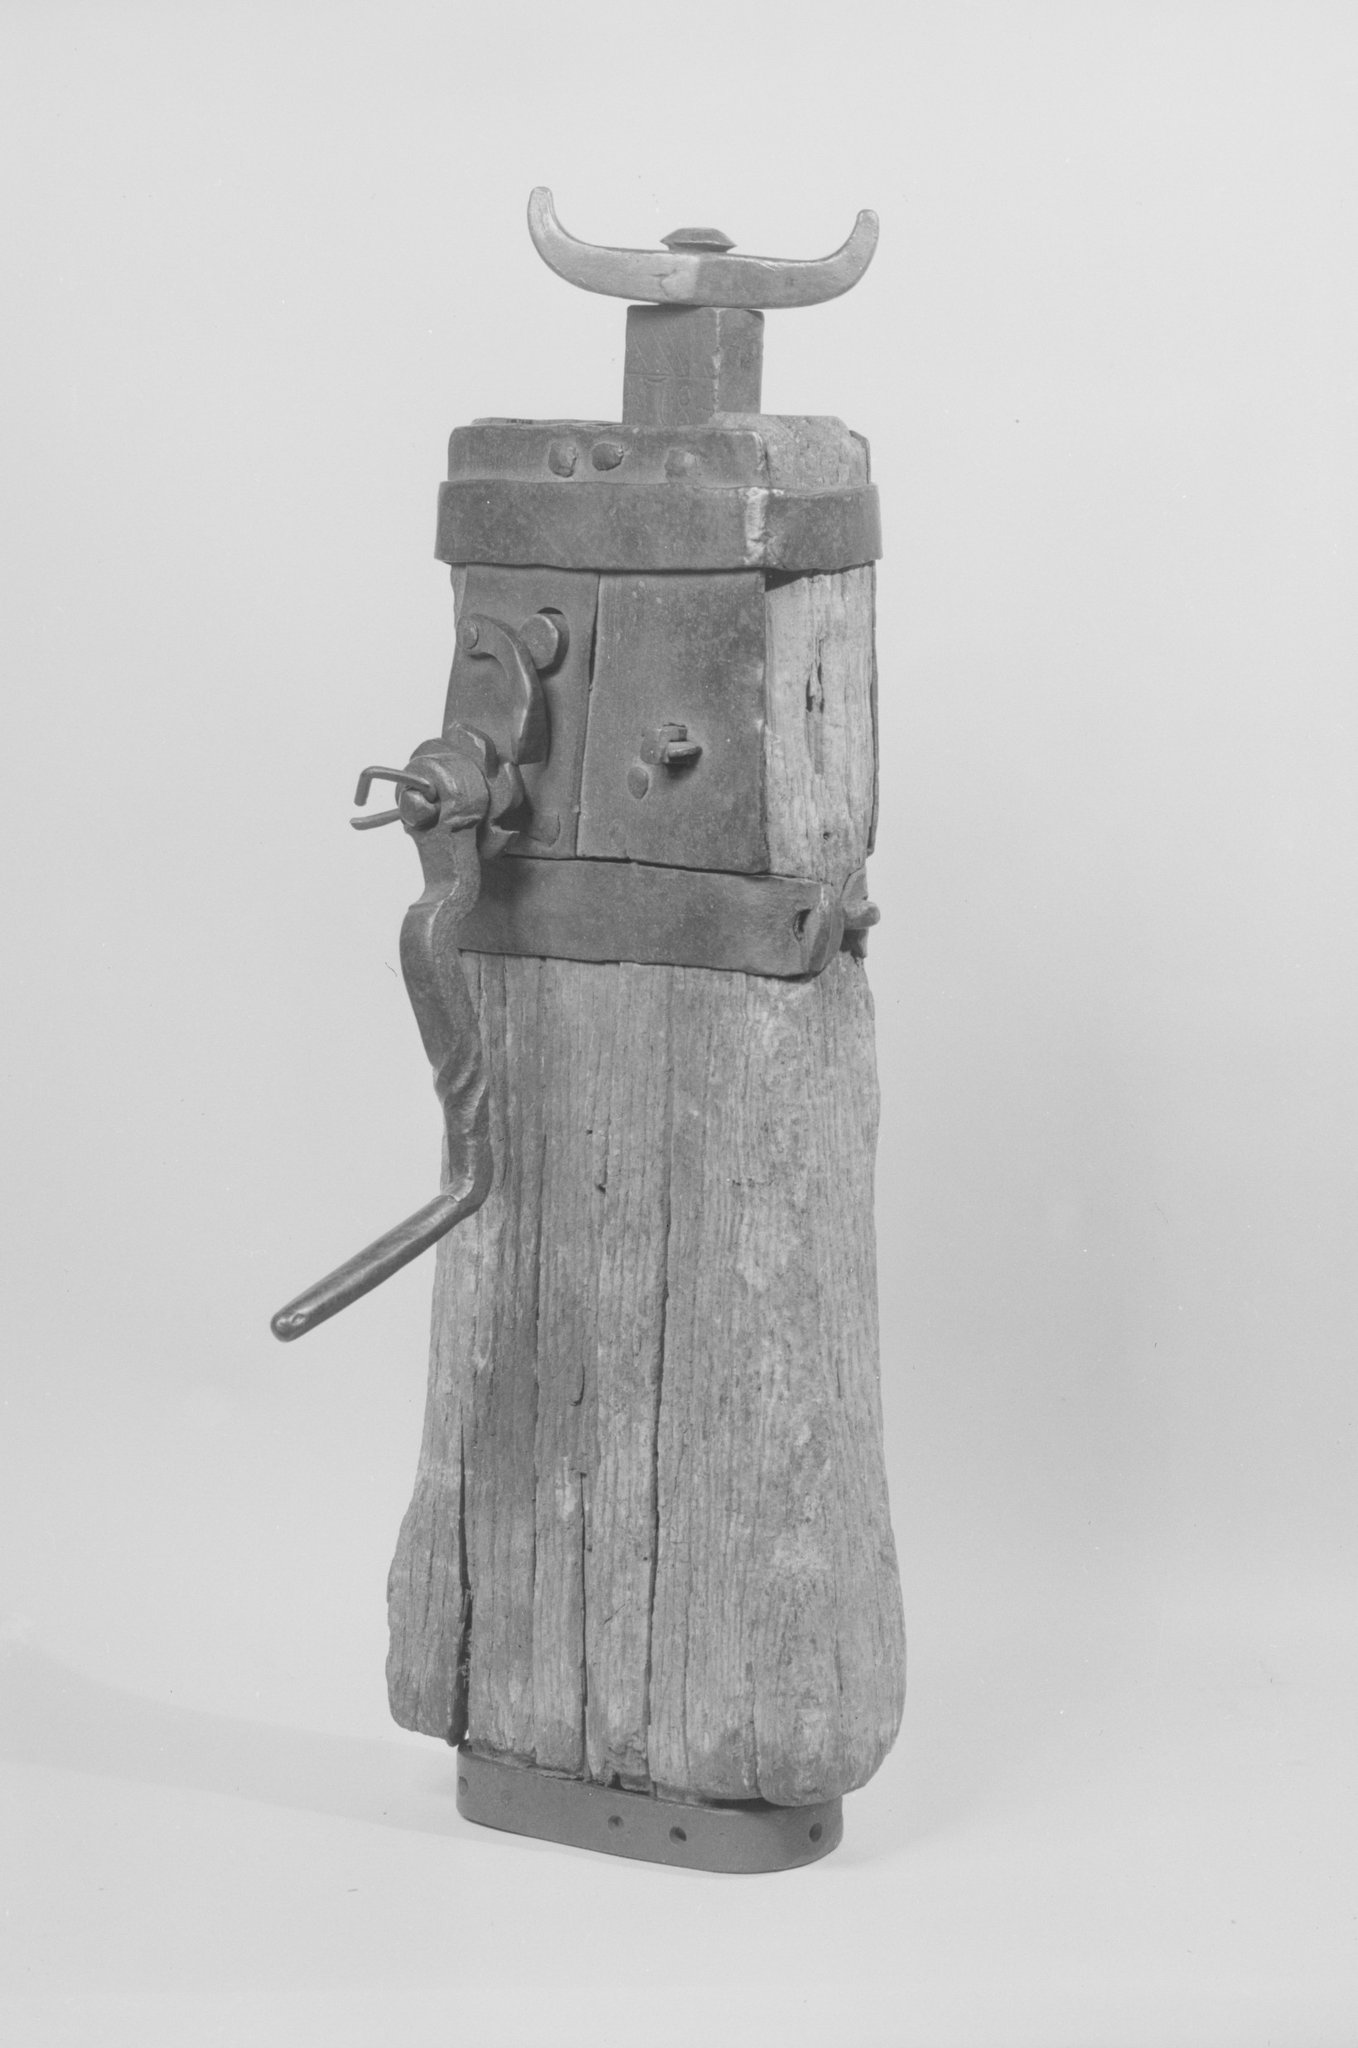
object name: jack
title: Conestoga Wagon Jack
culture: american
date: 1784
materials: iron, wood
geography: united states